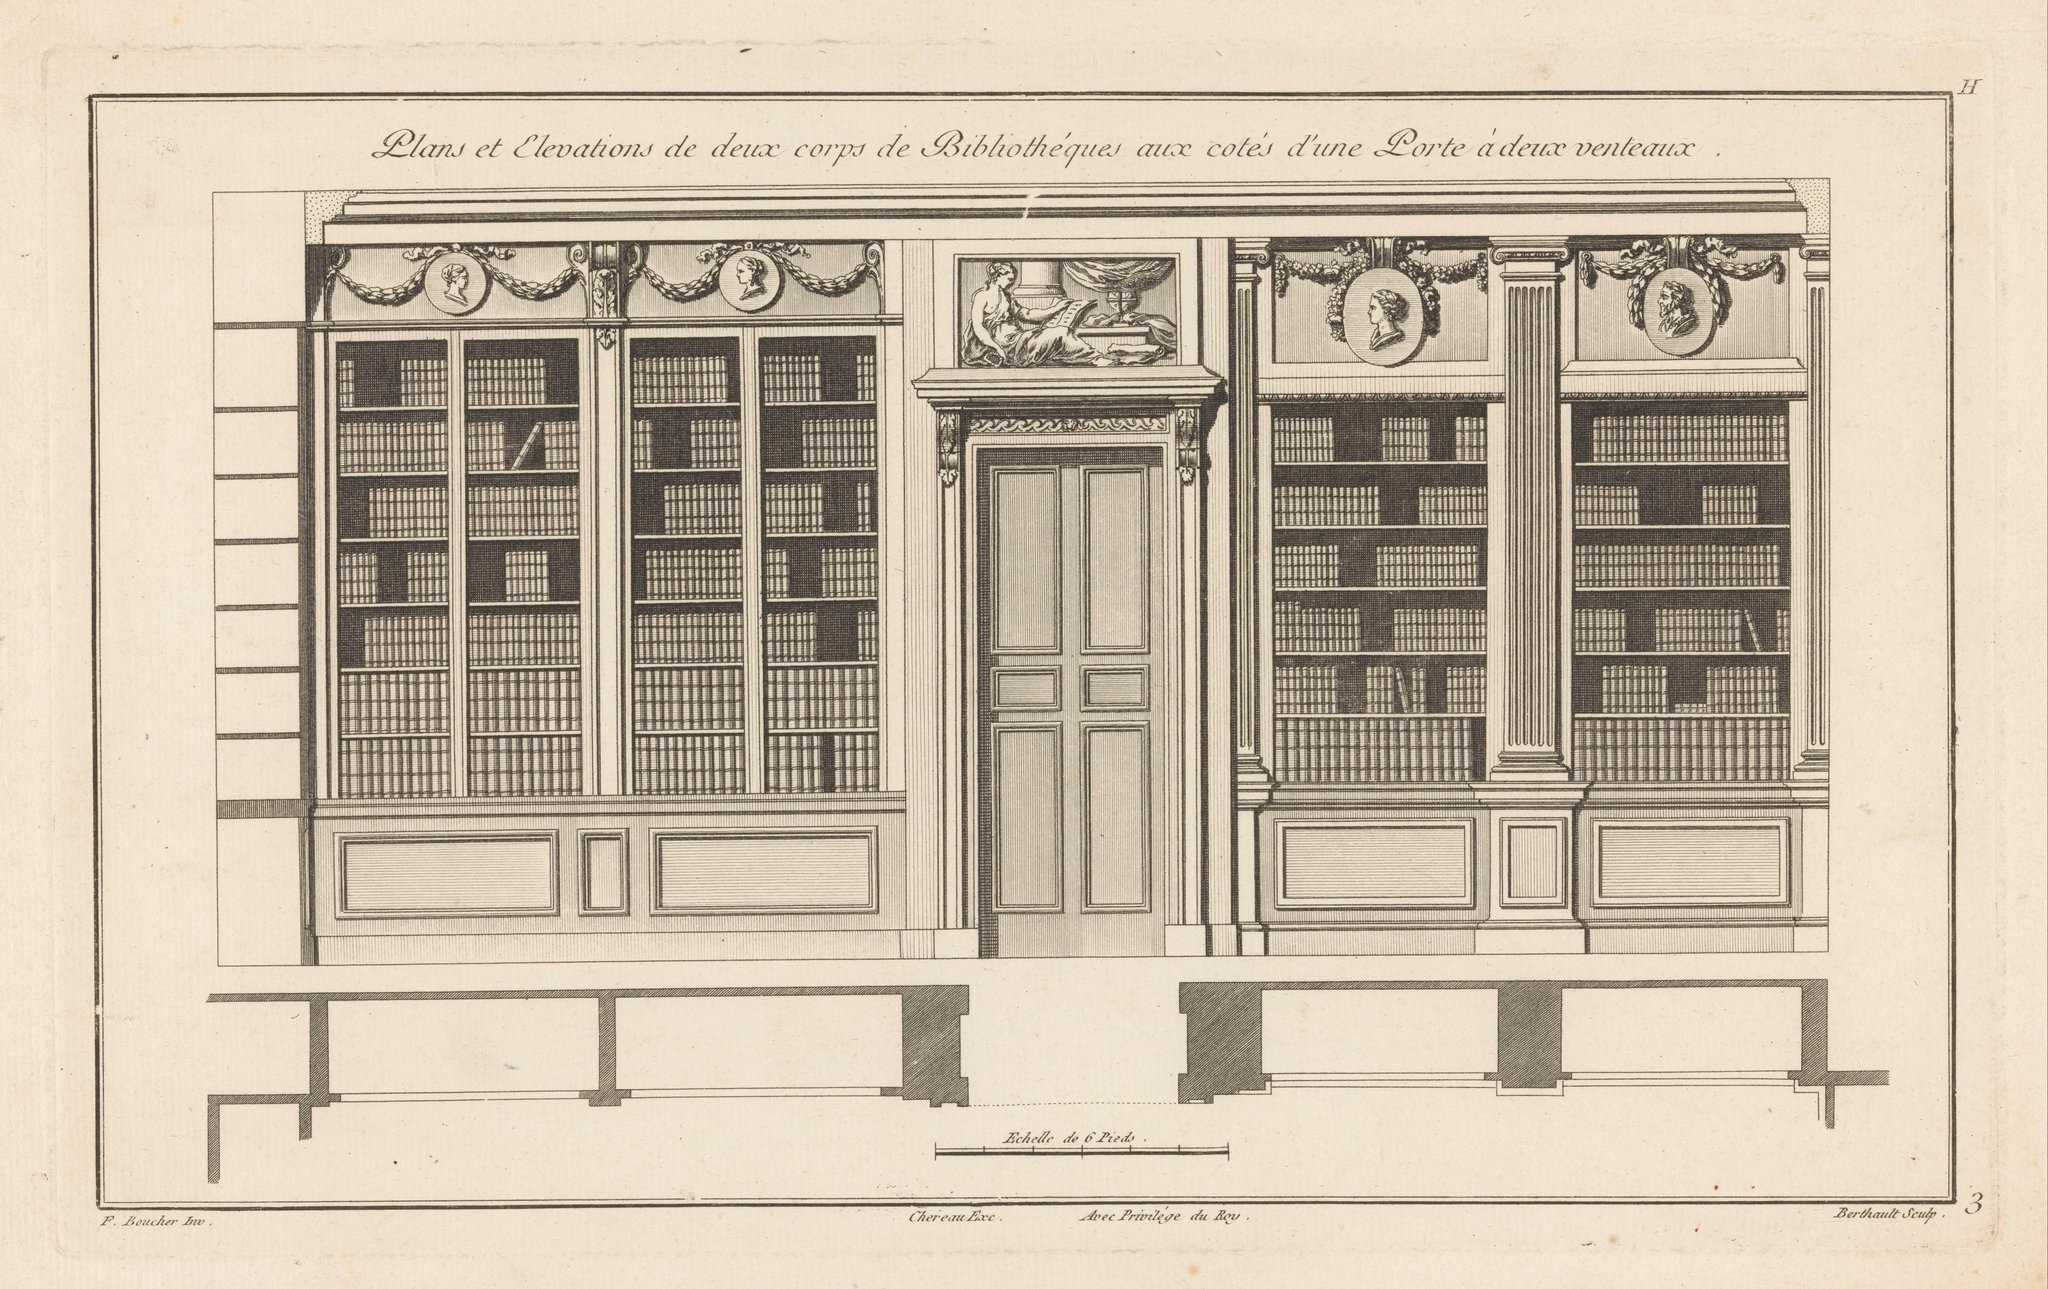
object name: ornament print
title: Plans et Elevations de deux corps de Bibliothéques aux cotés d'une Porte à deux venteaux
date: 1752-1794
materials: paper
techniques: engraving, etching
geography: paris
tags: bookshelves, reading, ornament ~ medallion, door, ornament ~ festoon, garland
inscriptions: collector's mark: Lugt 2760, collector's mark: Lugt 2228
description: Ontwerp en plattegrond van twee boekenkasten aan weerszijden van een deur met dessus-de-porte met een lezende vrouw. Boven de kasten panelen met guirlandes en portretten en profil in medaillons.